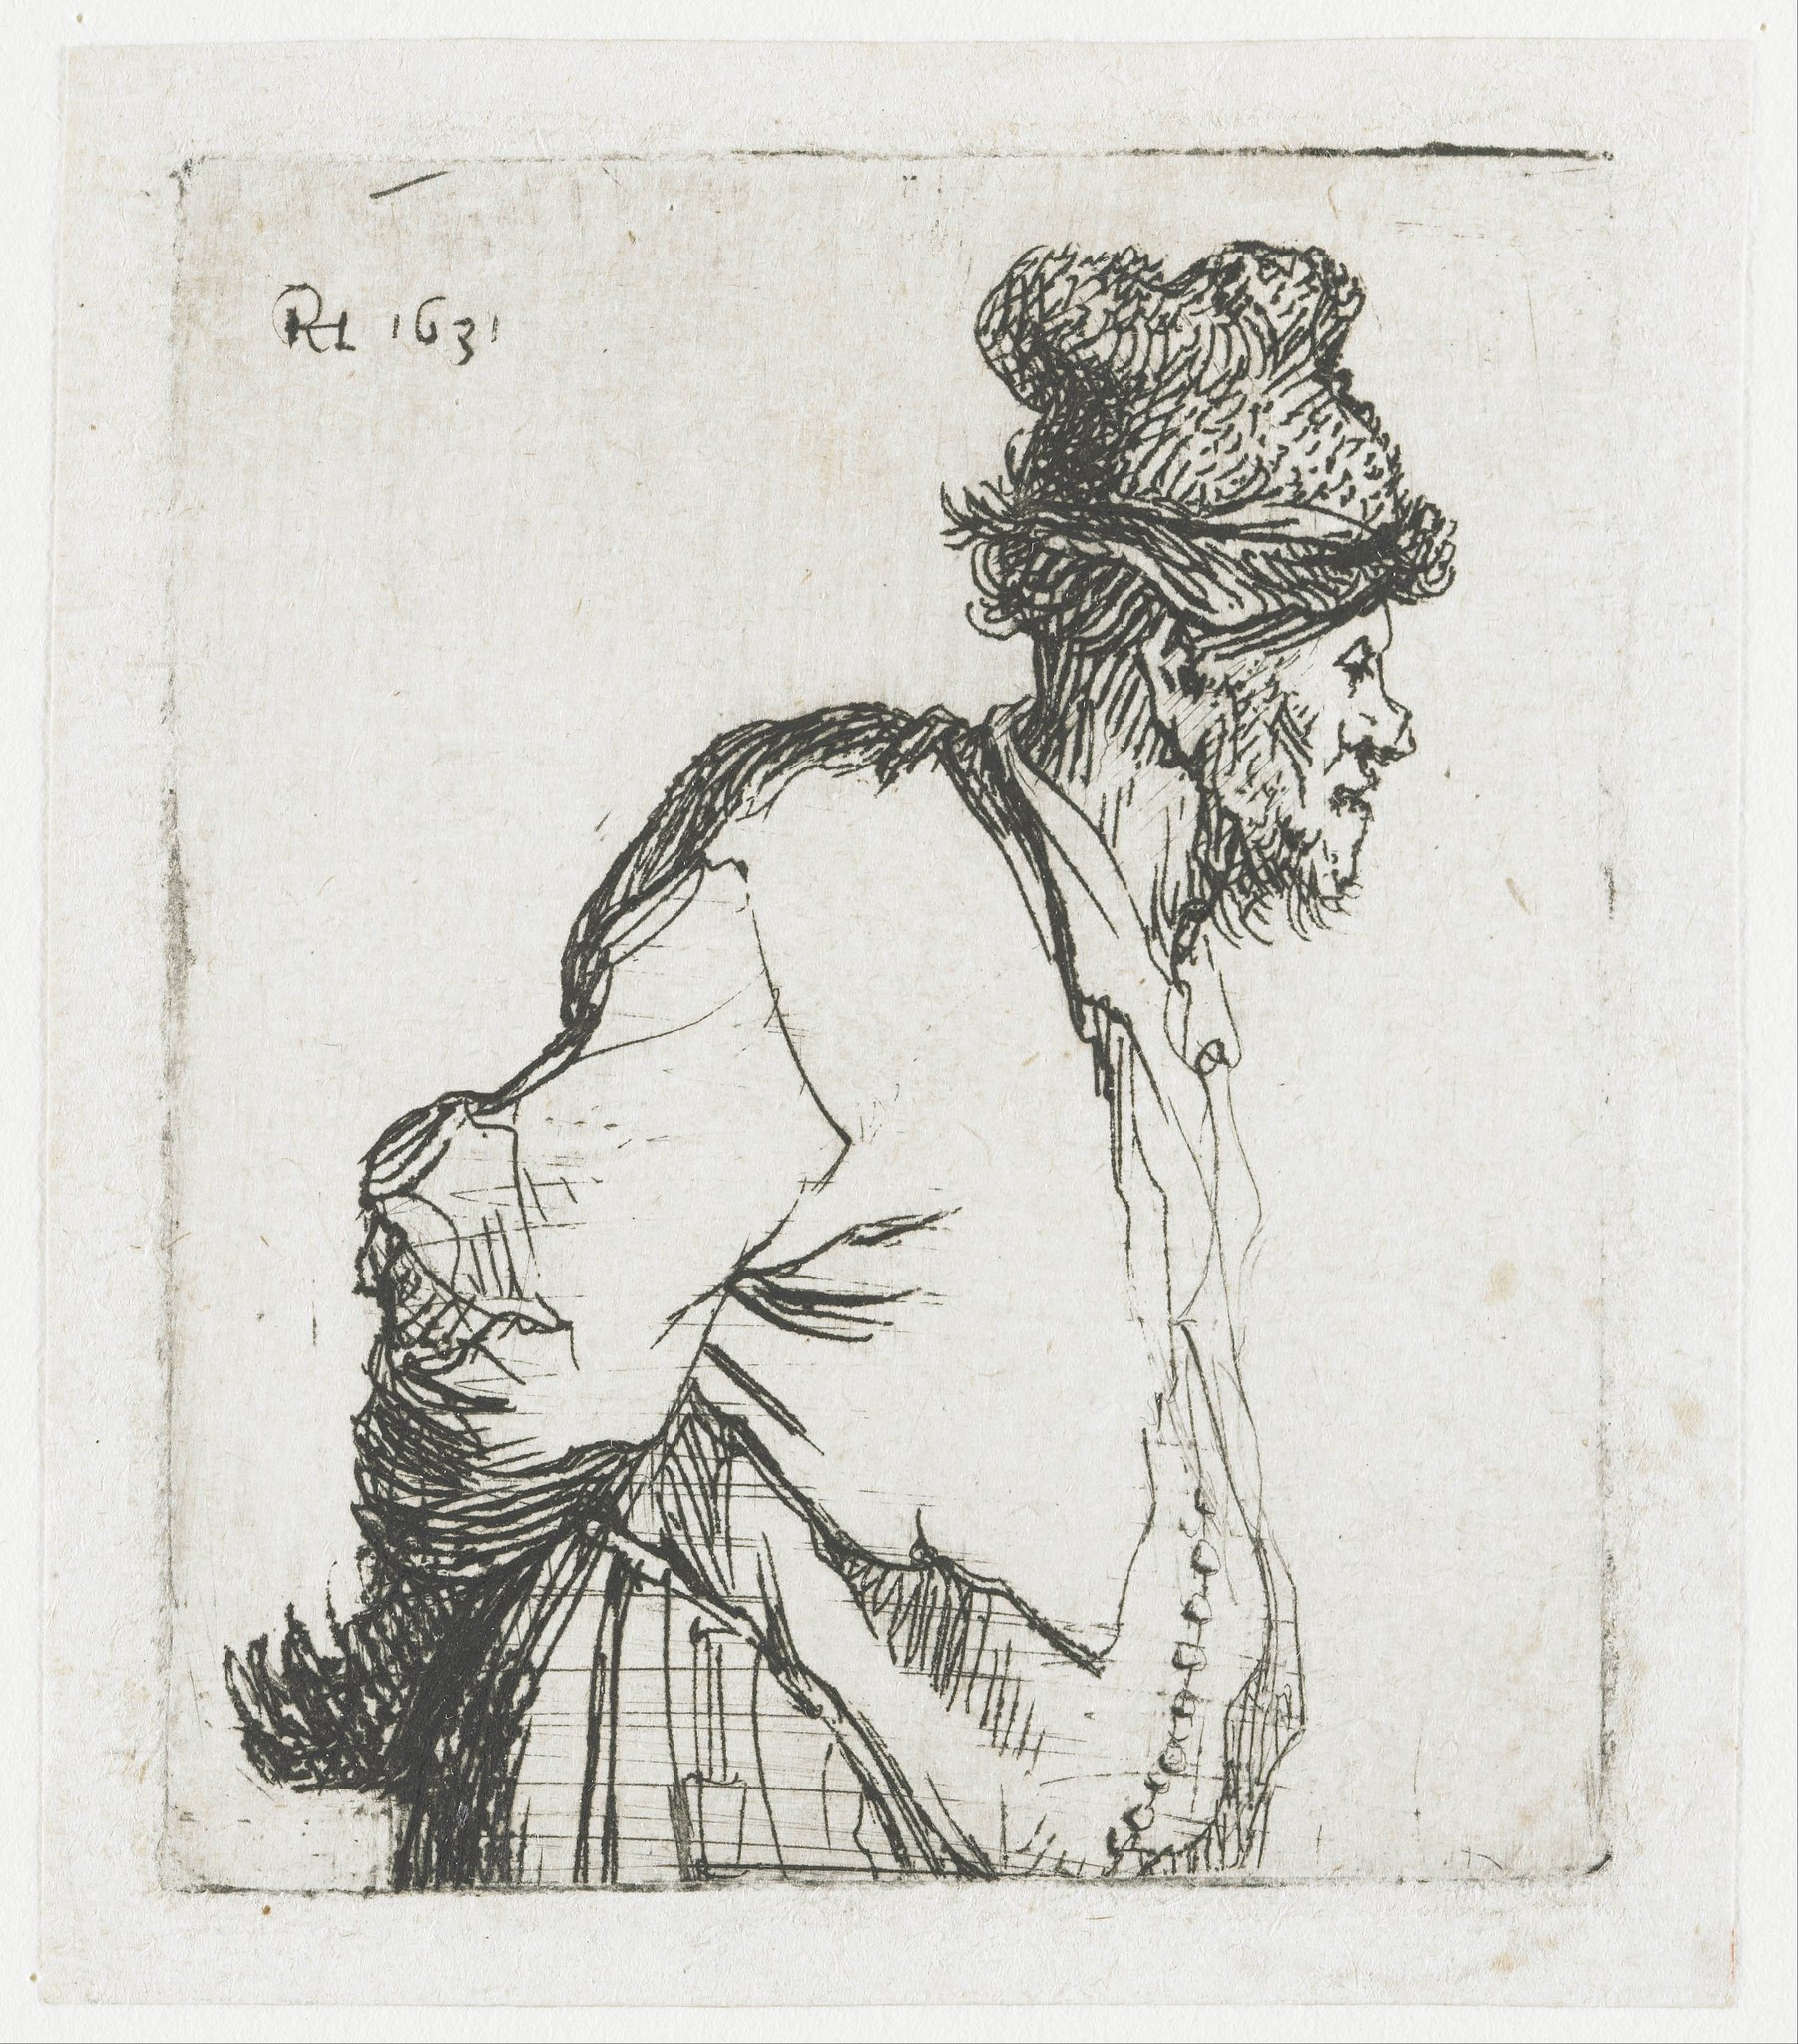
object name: print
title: Peasant with his hands behind his back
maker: rembrandt van rijn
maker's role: draughtsman, painter, print maker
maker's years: 1606-1669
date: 1629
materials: paper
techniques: etching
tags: adult man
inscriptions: monogram and date: ‘RHL 1631’, collector's mark: Lugt 240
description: De prent is gedateerd 1631, maar mogelijk niet door Rembrandt.